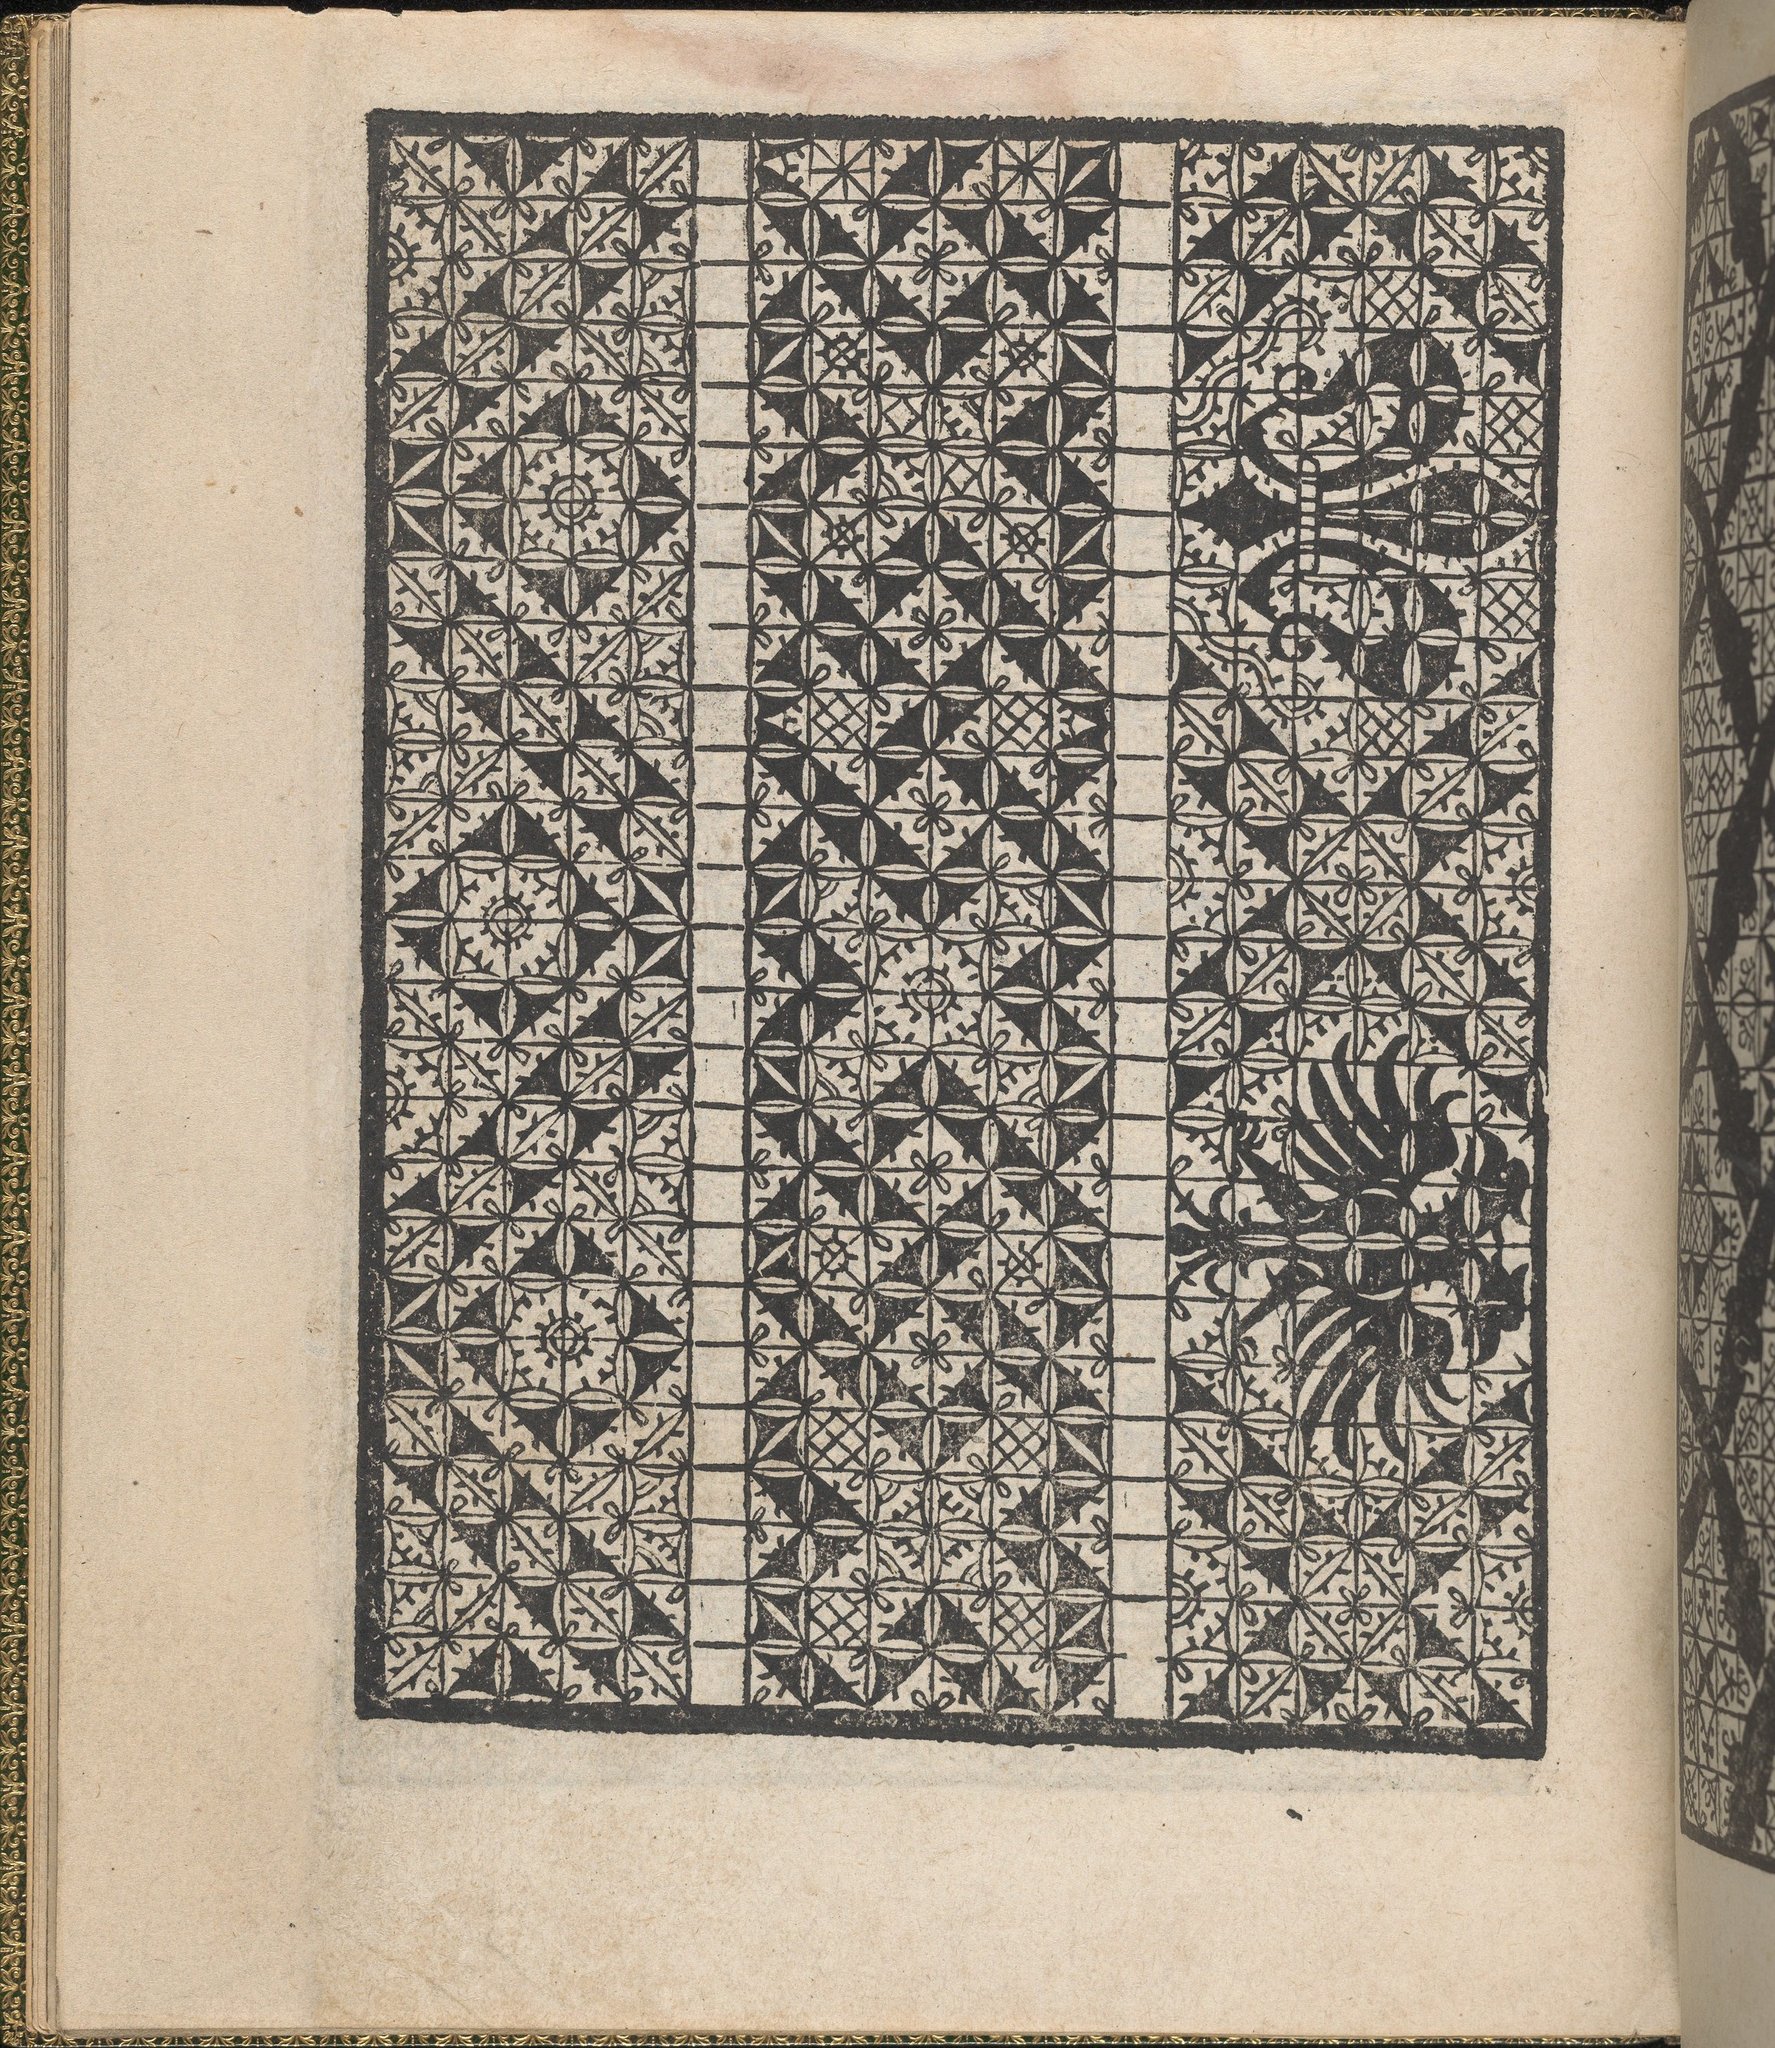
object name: book print ornament architecture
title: Giardineto novo di punti tagliati et gropposi per exercitio & ornamento delle donne (Venice 1554), page 19 (verso)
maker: matteo pagano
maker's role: publisher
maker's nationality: italian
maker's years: 1515-1588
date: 1554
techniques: woodcut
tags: ornament